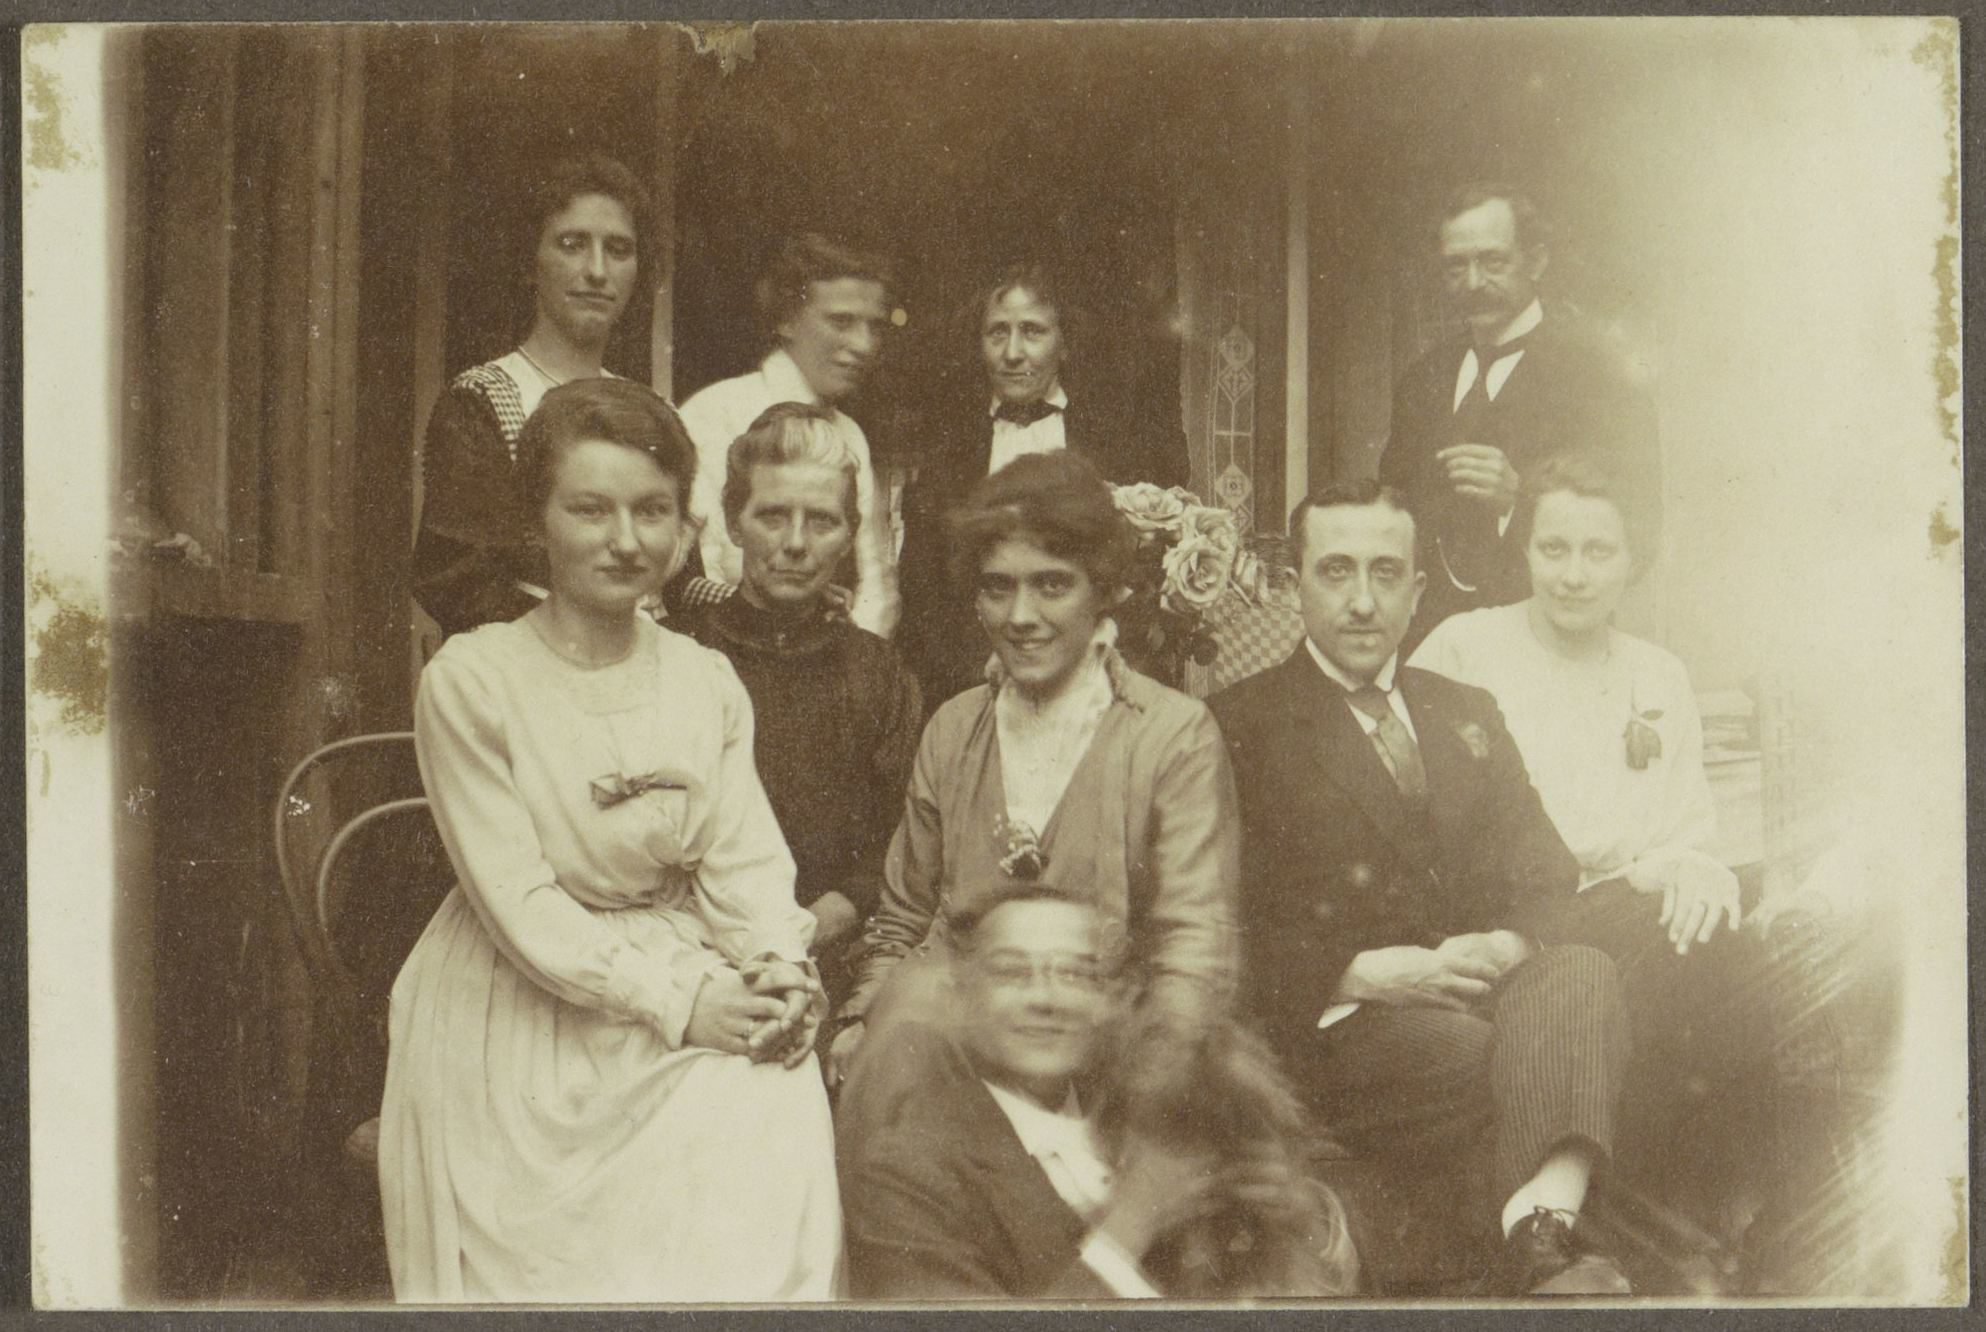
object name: album leaf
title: Groepsportret van een groep mannen en vrouwen, vermoedelijk bij een feestelijke gelegenheid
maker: Anonymous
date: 1920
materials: cardboard, paper, photographic support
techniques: daylight paper print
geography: netherlands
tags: adult woman, adult man, historical persons, flowers: rose, netherlands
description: Onderdeel van Fotoalbum met portretten vervaardigd door Nederlandse studio's waaronder automaatfoto's.